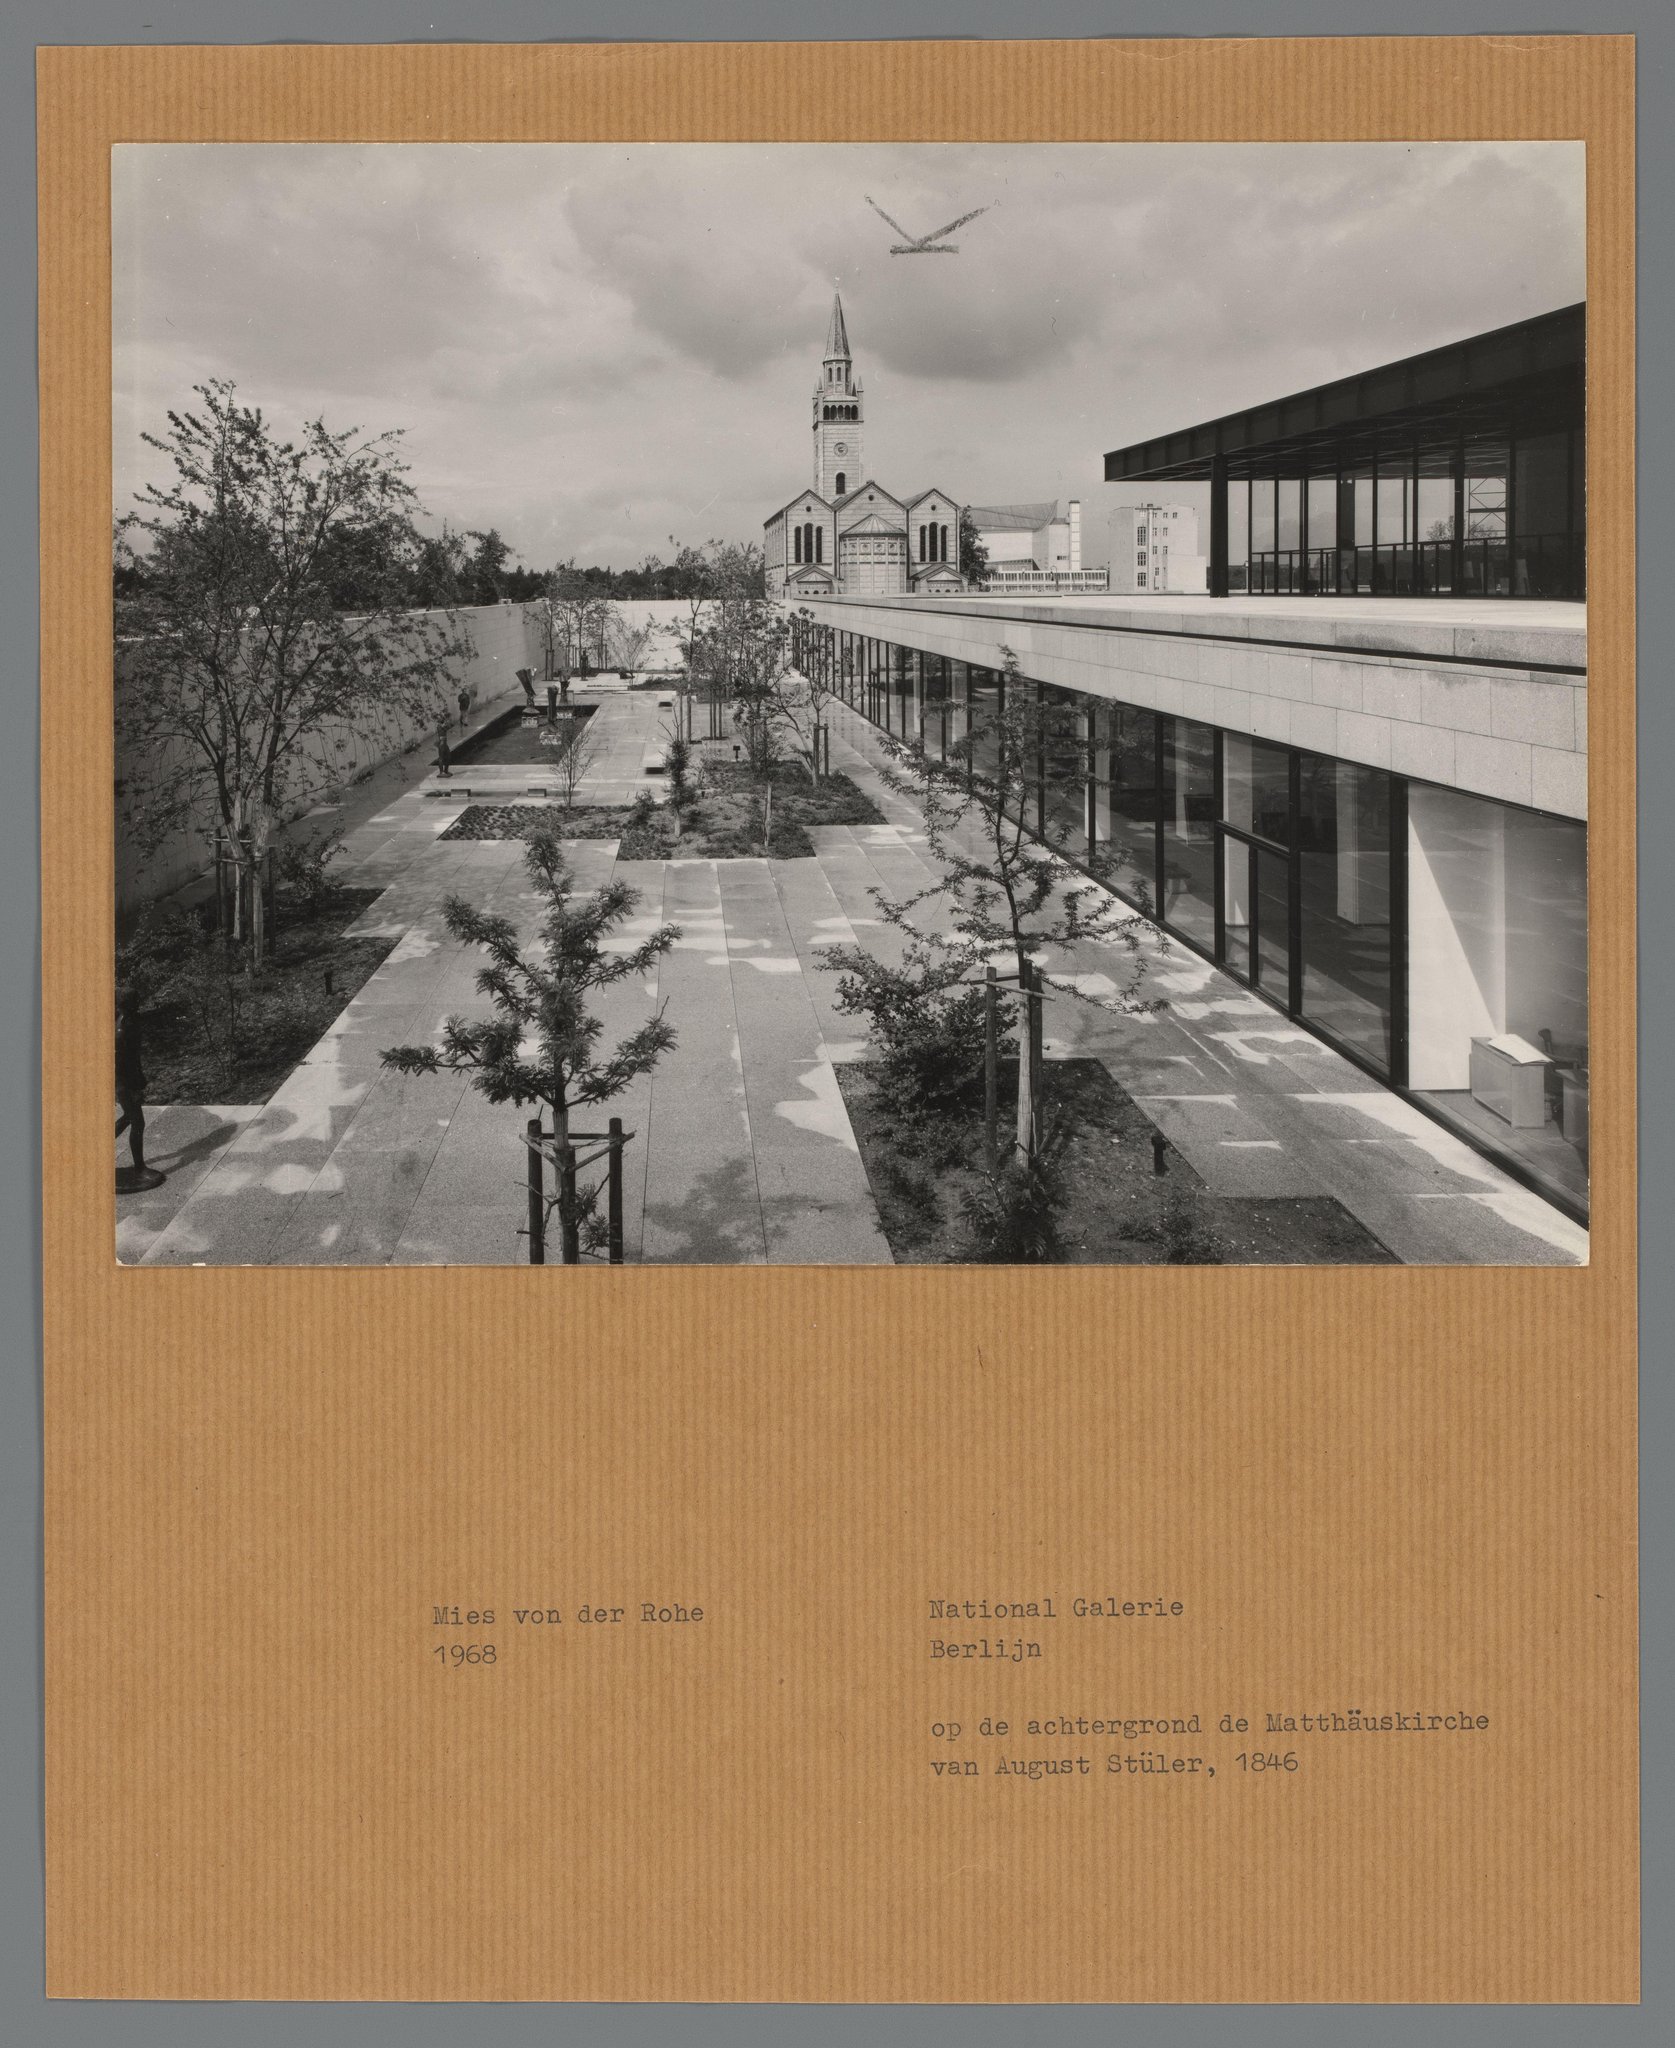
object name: photograph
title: Neue Nationalgalerie van Mies van der Rohe, Berlijn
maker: reinhard friedrich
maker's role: fotograaf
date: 1968-1975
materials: photographic support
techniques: gelatin silver print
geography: berlin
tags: moskou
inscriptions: annotation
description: Een foto van Neue Nationalgalerie op drager.